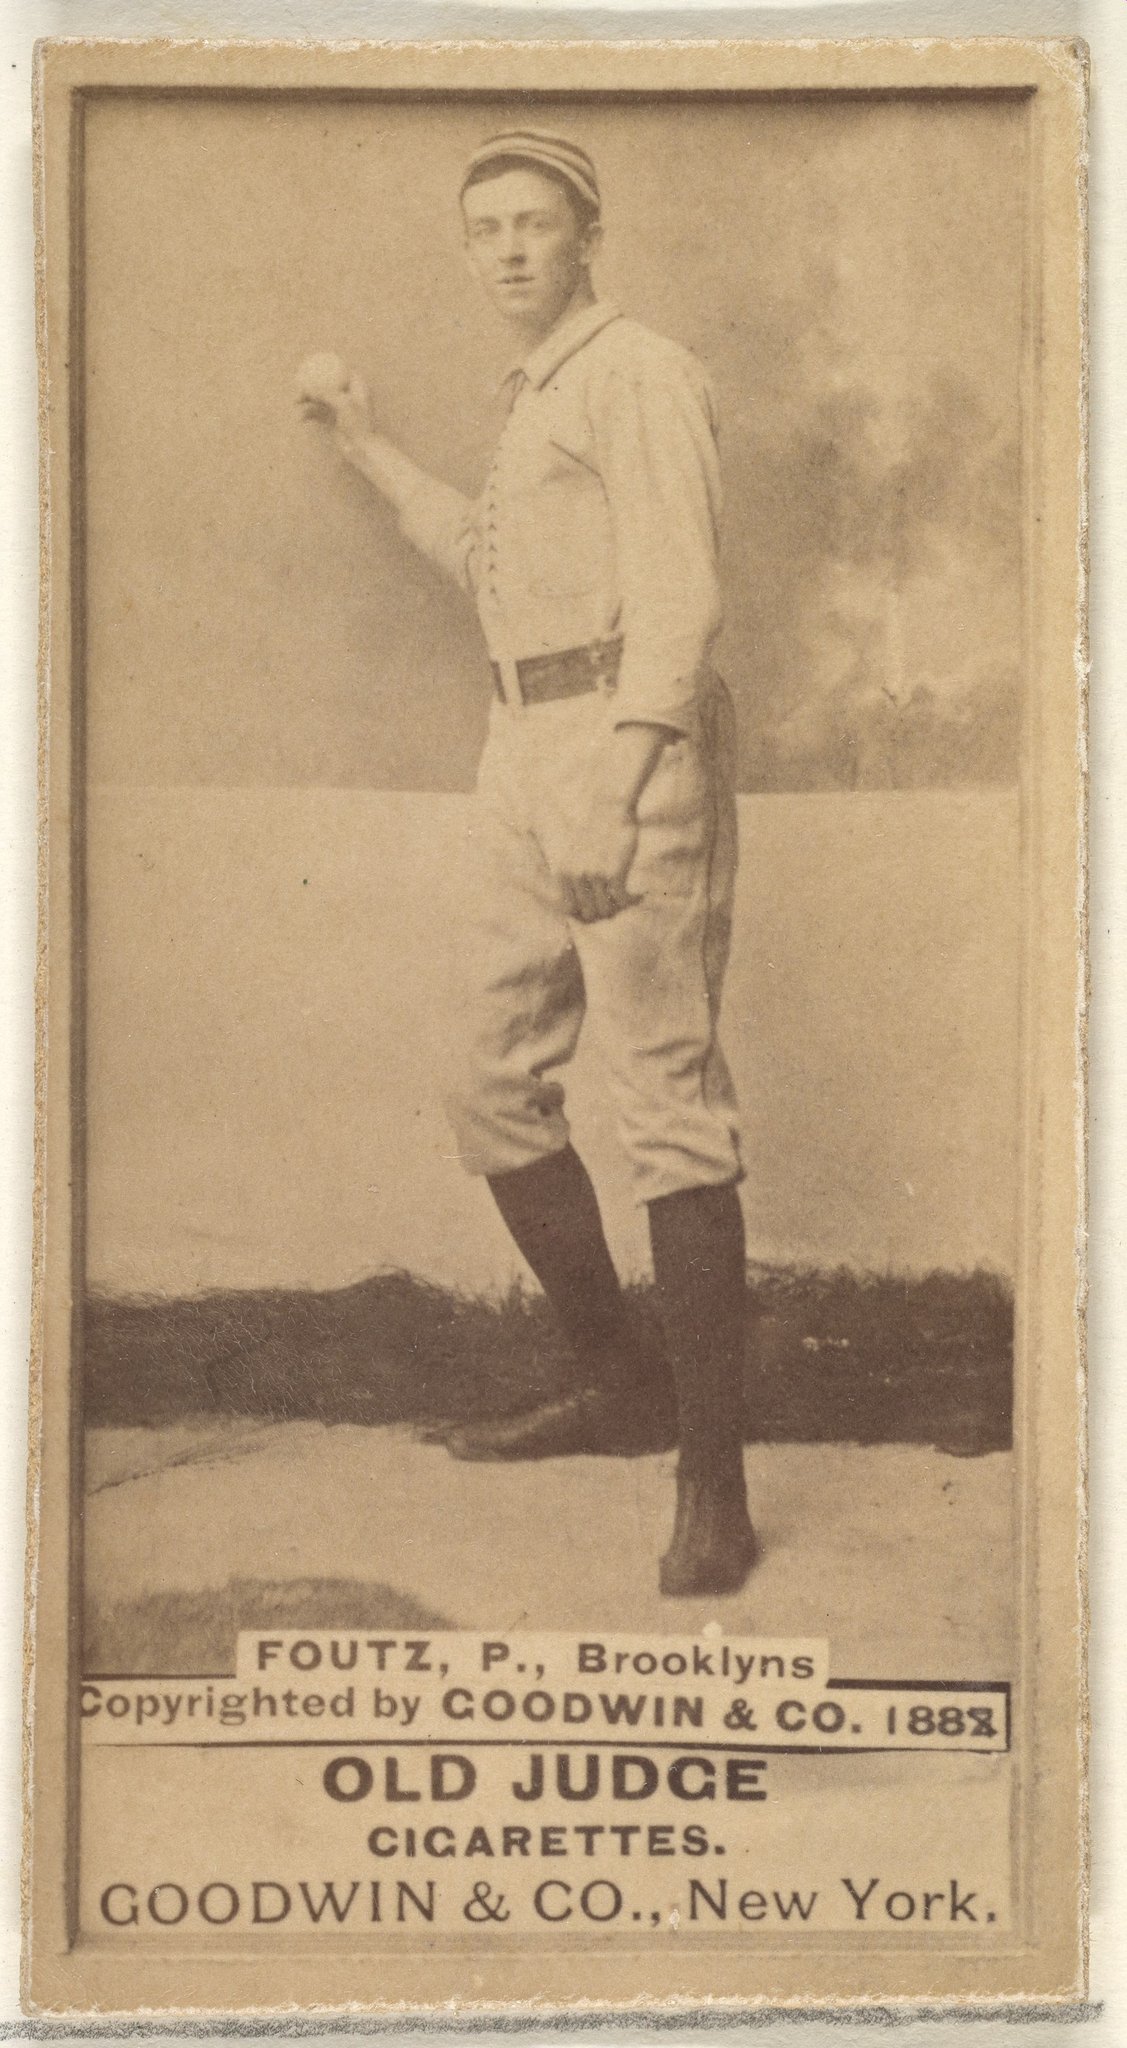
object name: baseball card, photograph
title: Foutz, Pitcher, Brooklyn Bridegrooms, from the Old Judge series (N172) for Old Judge Cigarettes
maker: goodwin & company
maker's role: publisher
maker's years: 1850-1950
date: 1888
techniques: albumen silver print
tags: men,portraits,baseball,athletes